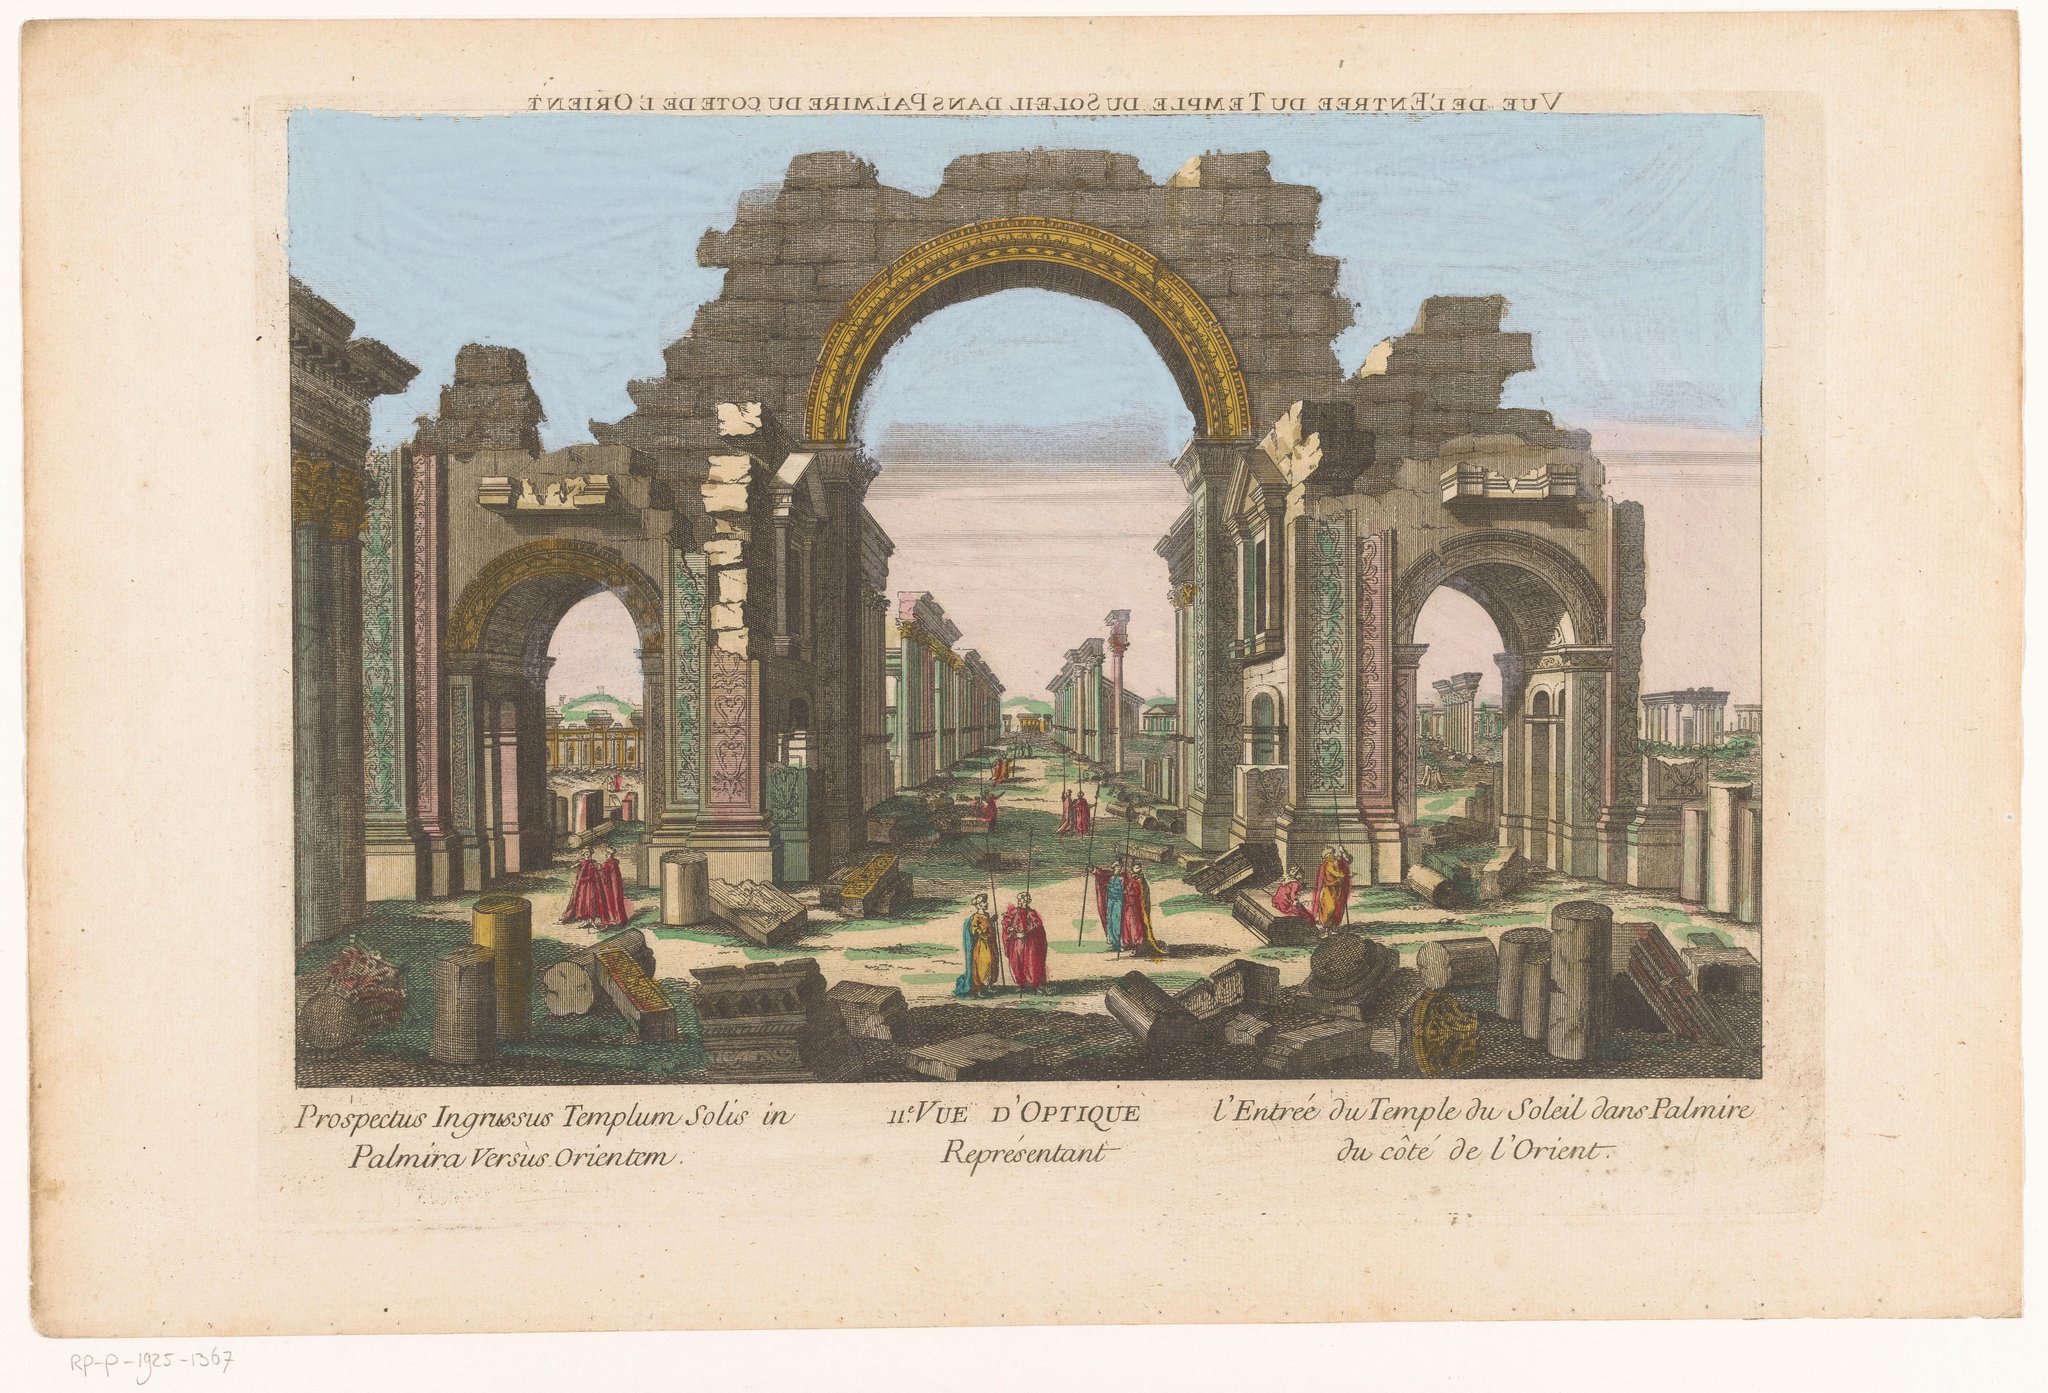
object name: opticaprent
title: Gezicht op de ruïne van de boog van de zuilengalerij te Palmyra, gezien vanaf de oostzijde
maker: Anonymous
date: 1700-1799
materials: paper, watercolor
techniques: brush, etching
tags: colonnade, arch, archivolt ~ architecture, landscape with ruins (+ city(-scape) with figures, staffage)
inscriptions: collector's mark: Lugt 2166, watermark